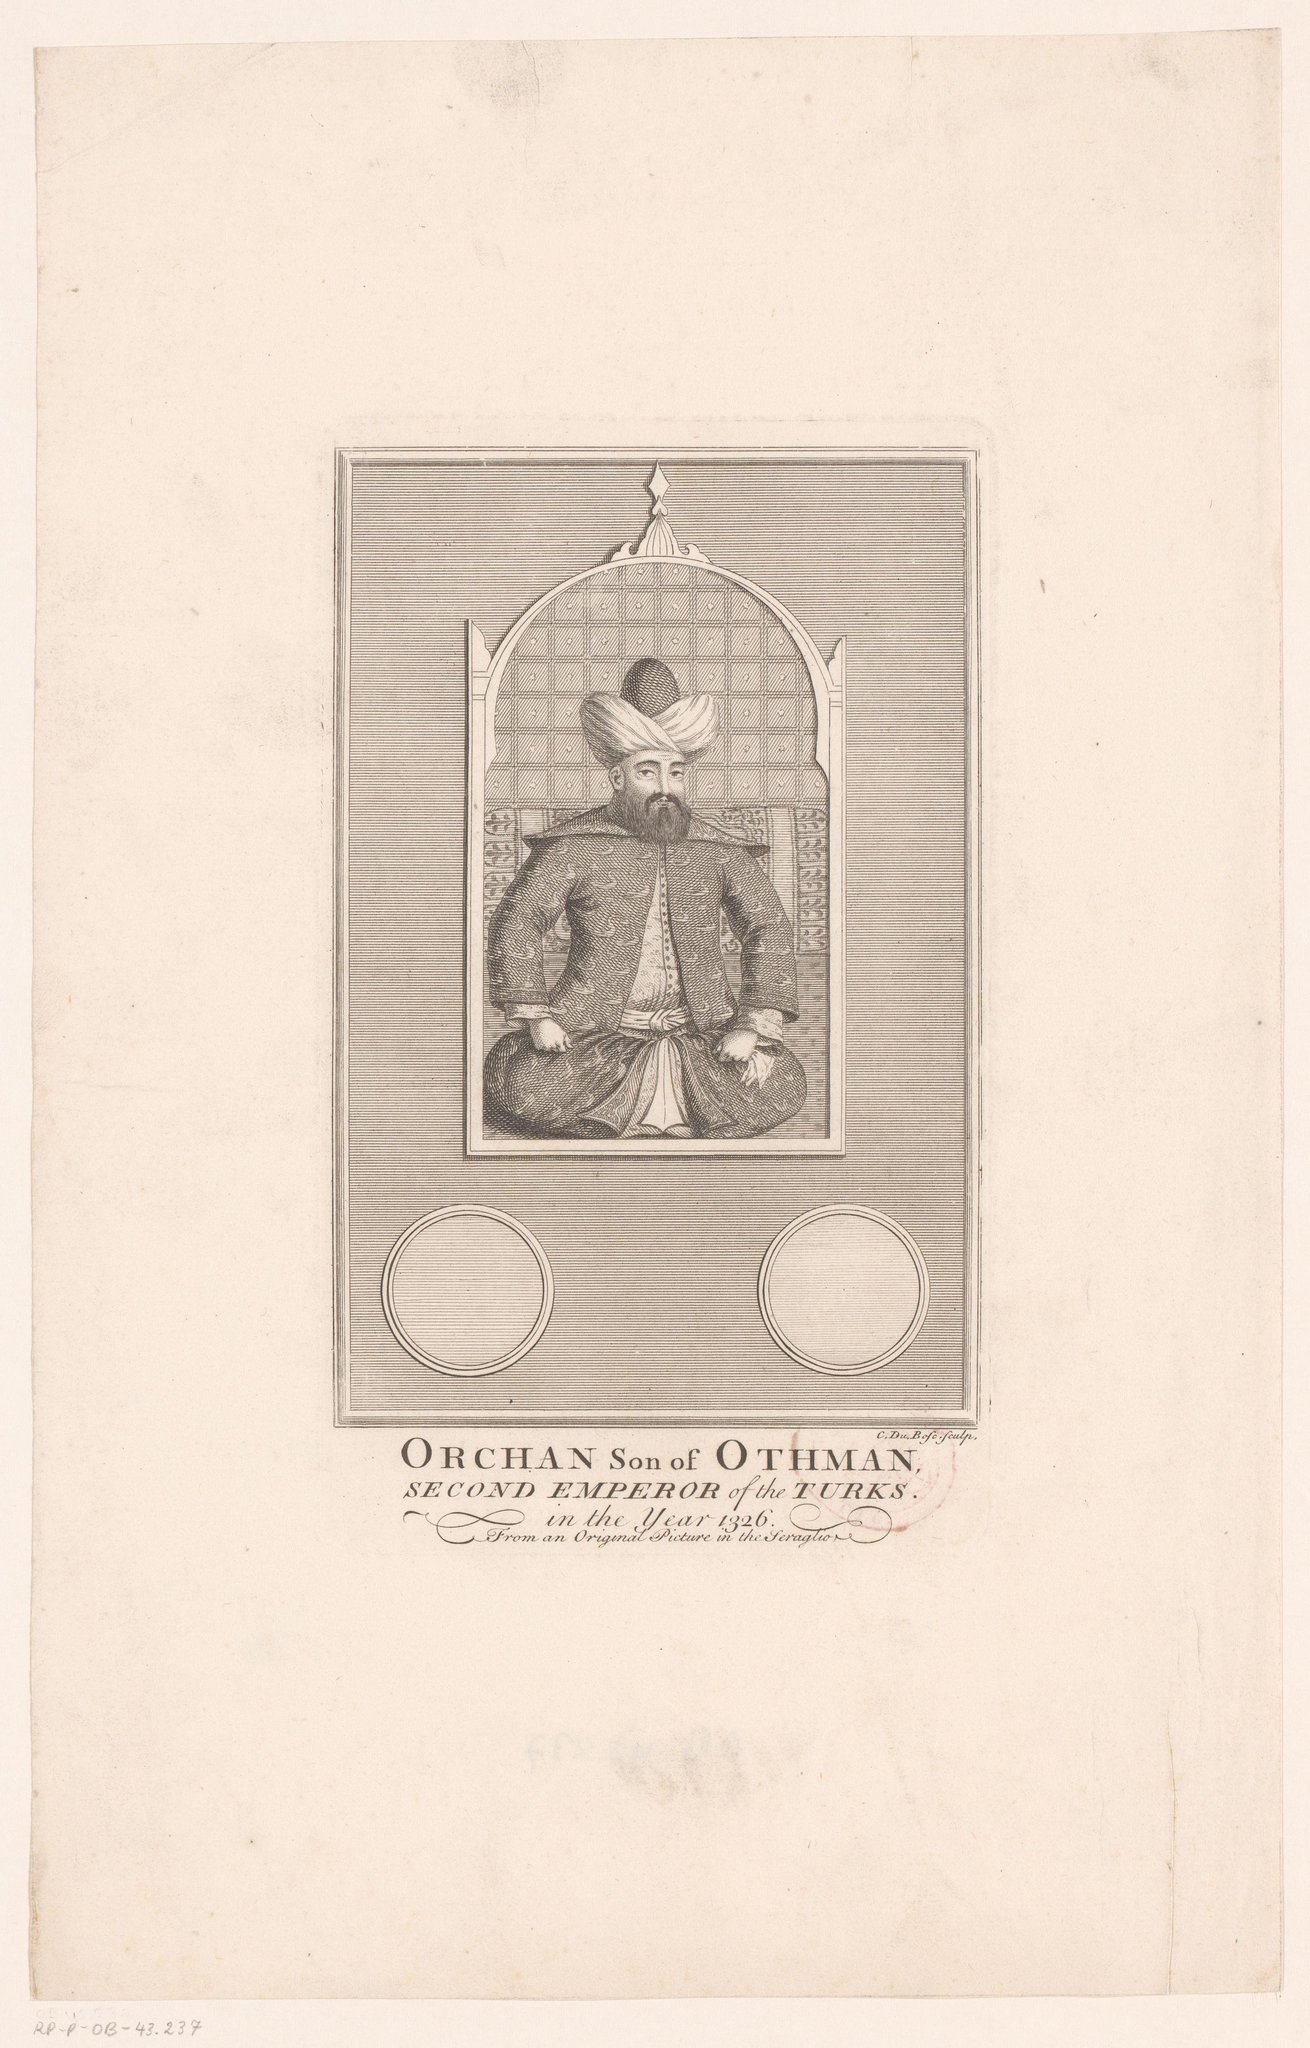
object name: print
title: Ottomaanse heersers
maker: claude dubosc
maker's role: print maker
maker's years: 1682-1745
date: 1692-1745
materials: paper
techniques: engraving, etching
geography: france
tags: historical persons, ruler, sovereign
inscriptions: collector's mark: Lugt 240